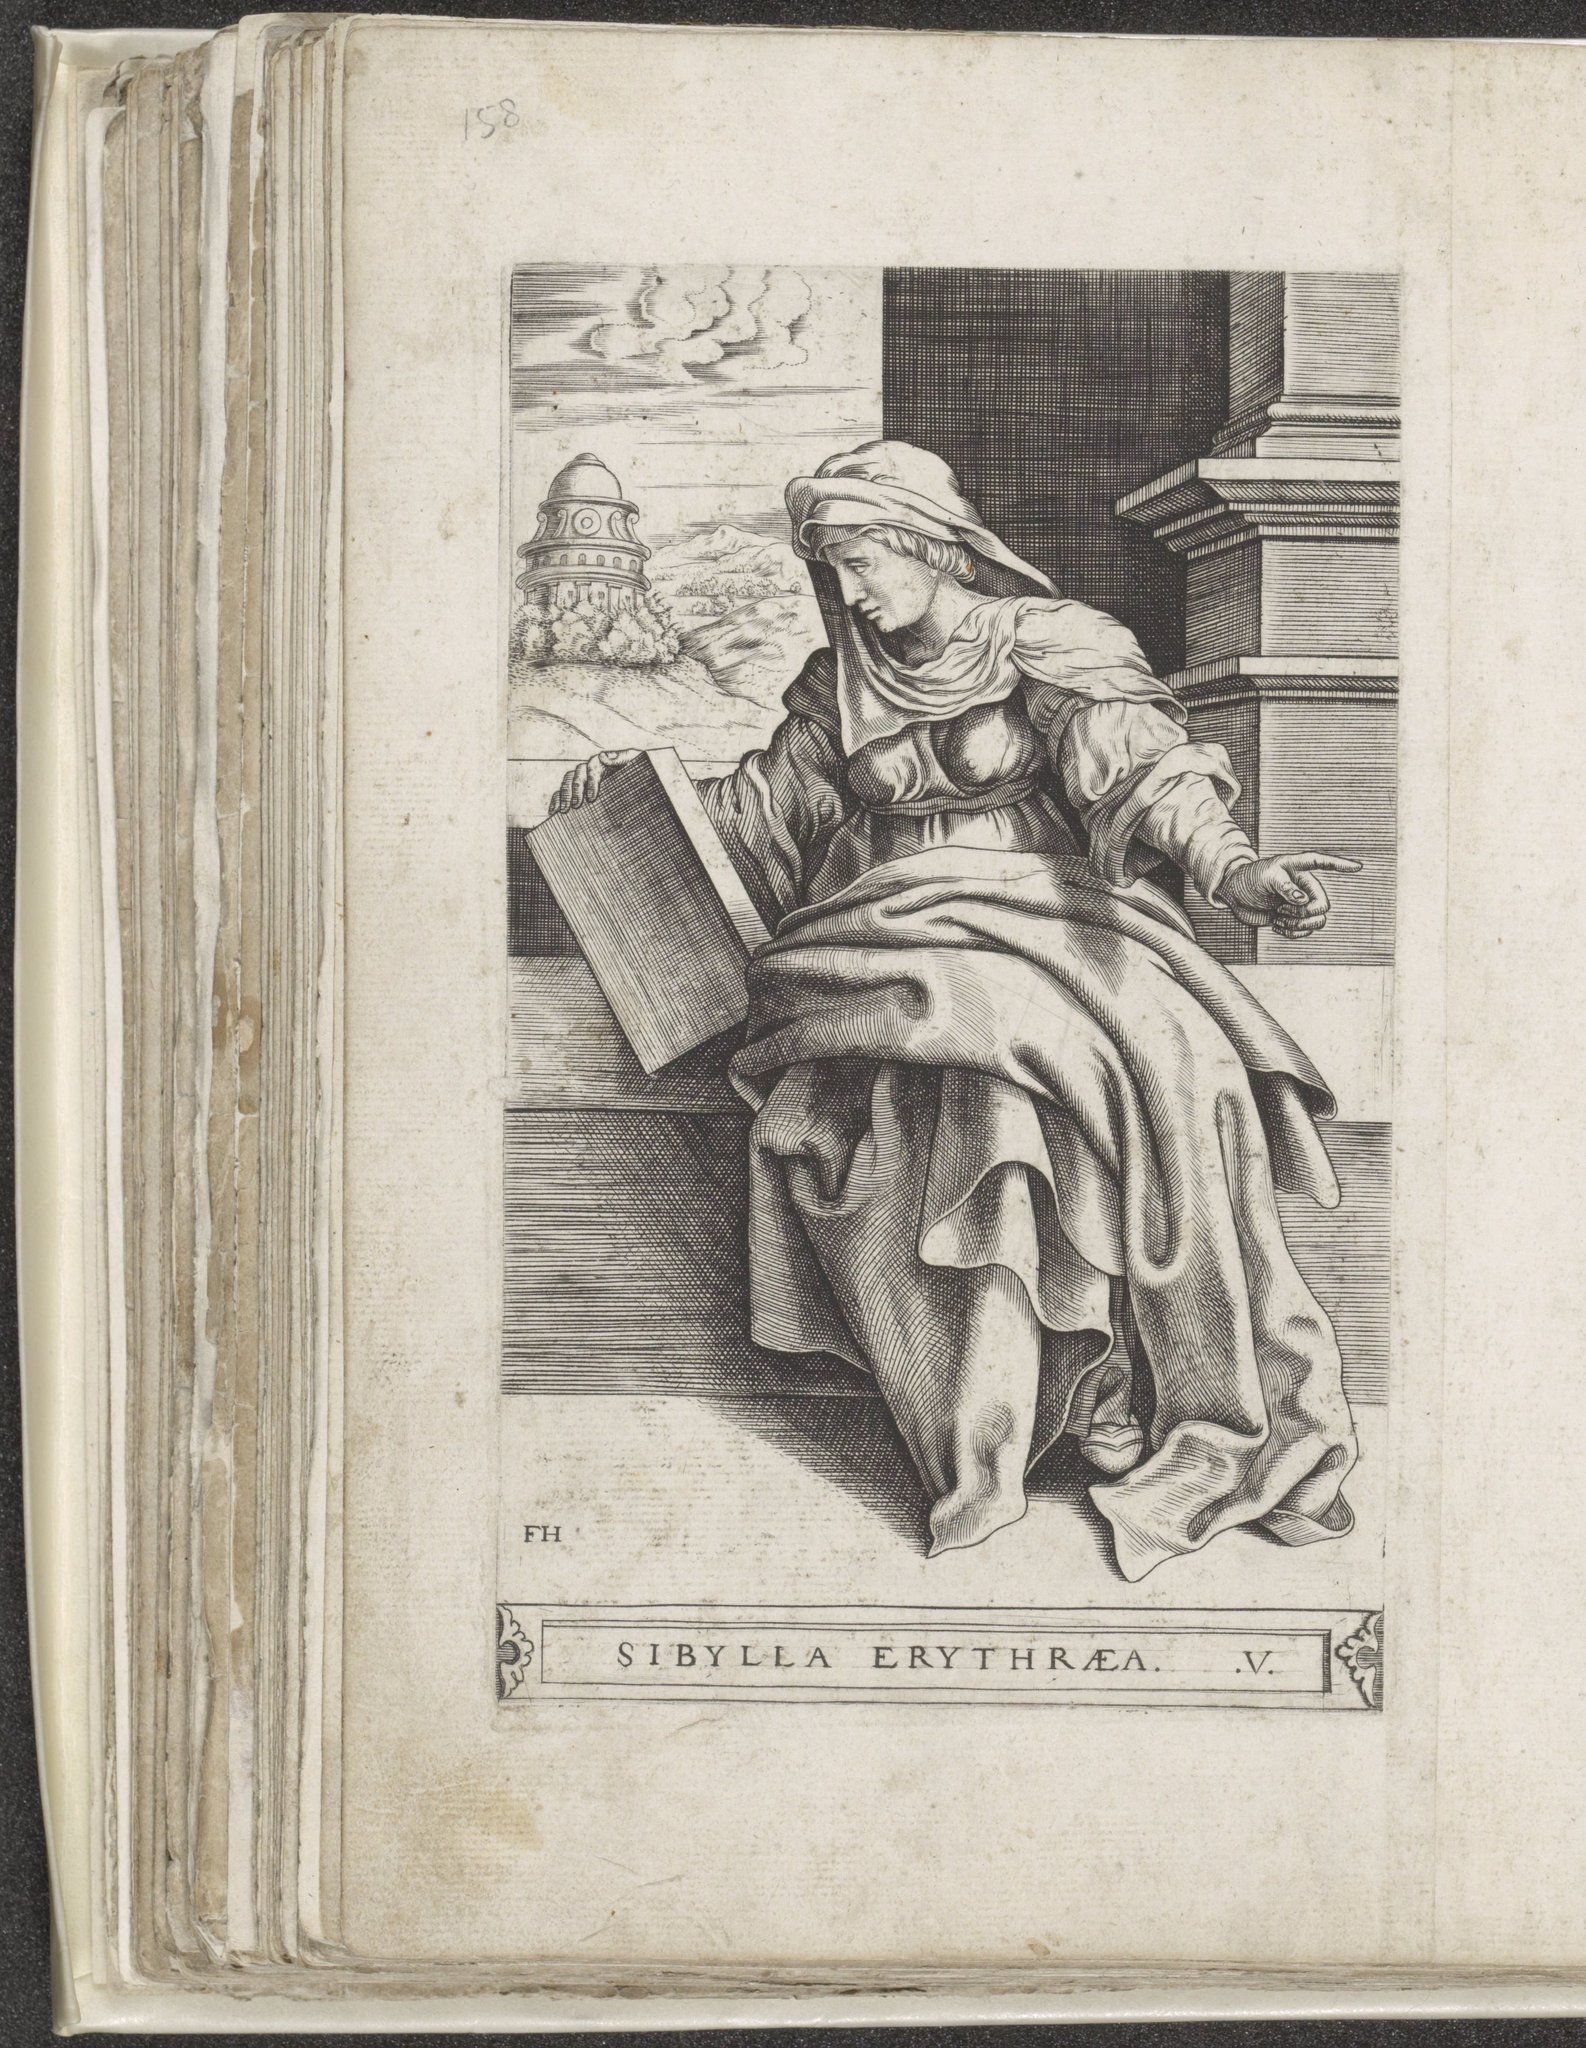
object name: album leaf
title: Sibylla Erythraea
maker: frans huys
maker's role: print maker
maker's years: 1522-1562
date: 1546-1562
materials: paper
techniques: engraving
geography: antwerp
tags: erythraean sibyl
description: De Sibille van Erythrae zittend met een boek in haar rechterhand en wijzende met haar linkerhand. Op de achtergrond links een rond gebouw in een landschap. Deze prent maakt deel uit van een album.